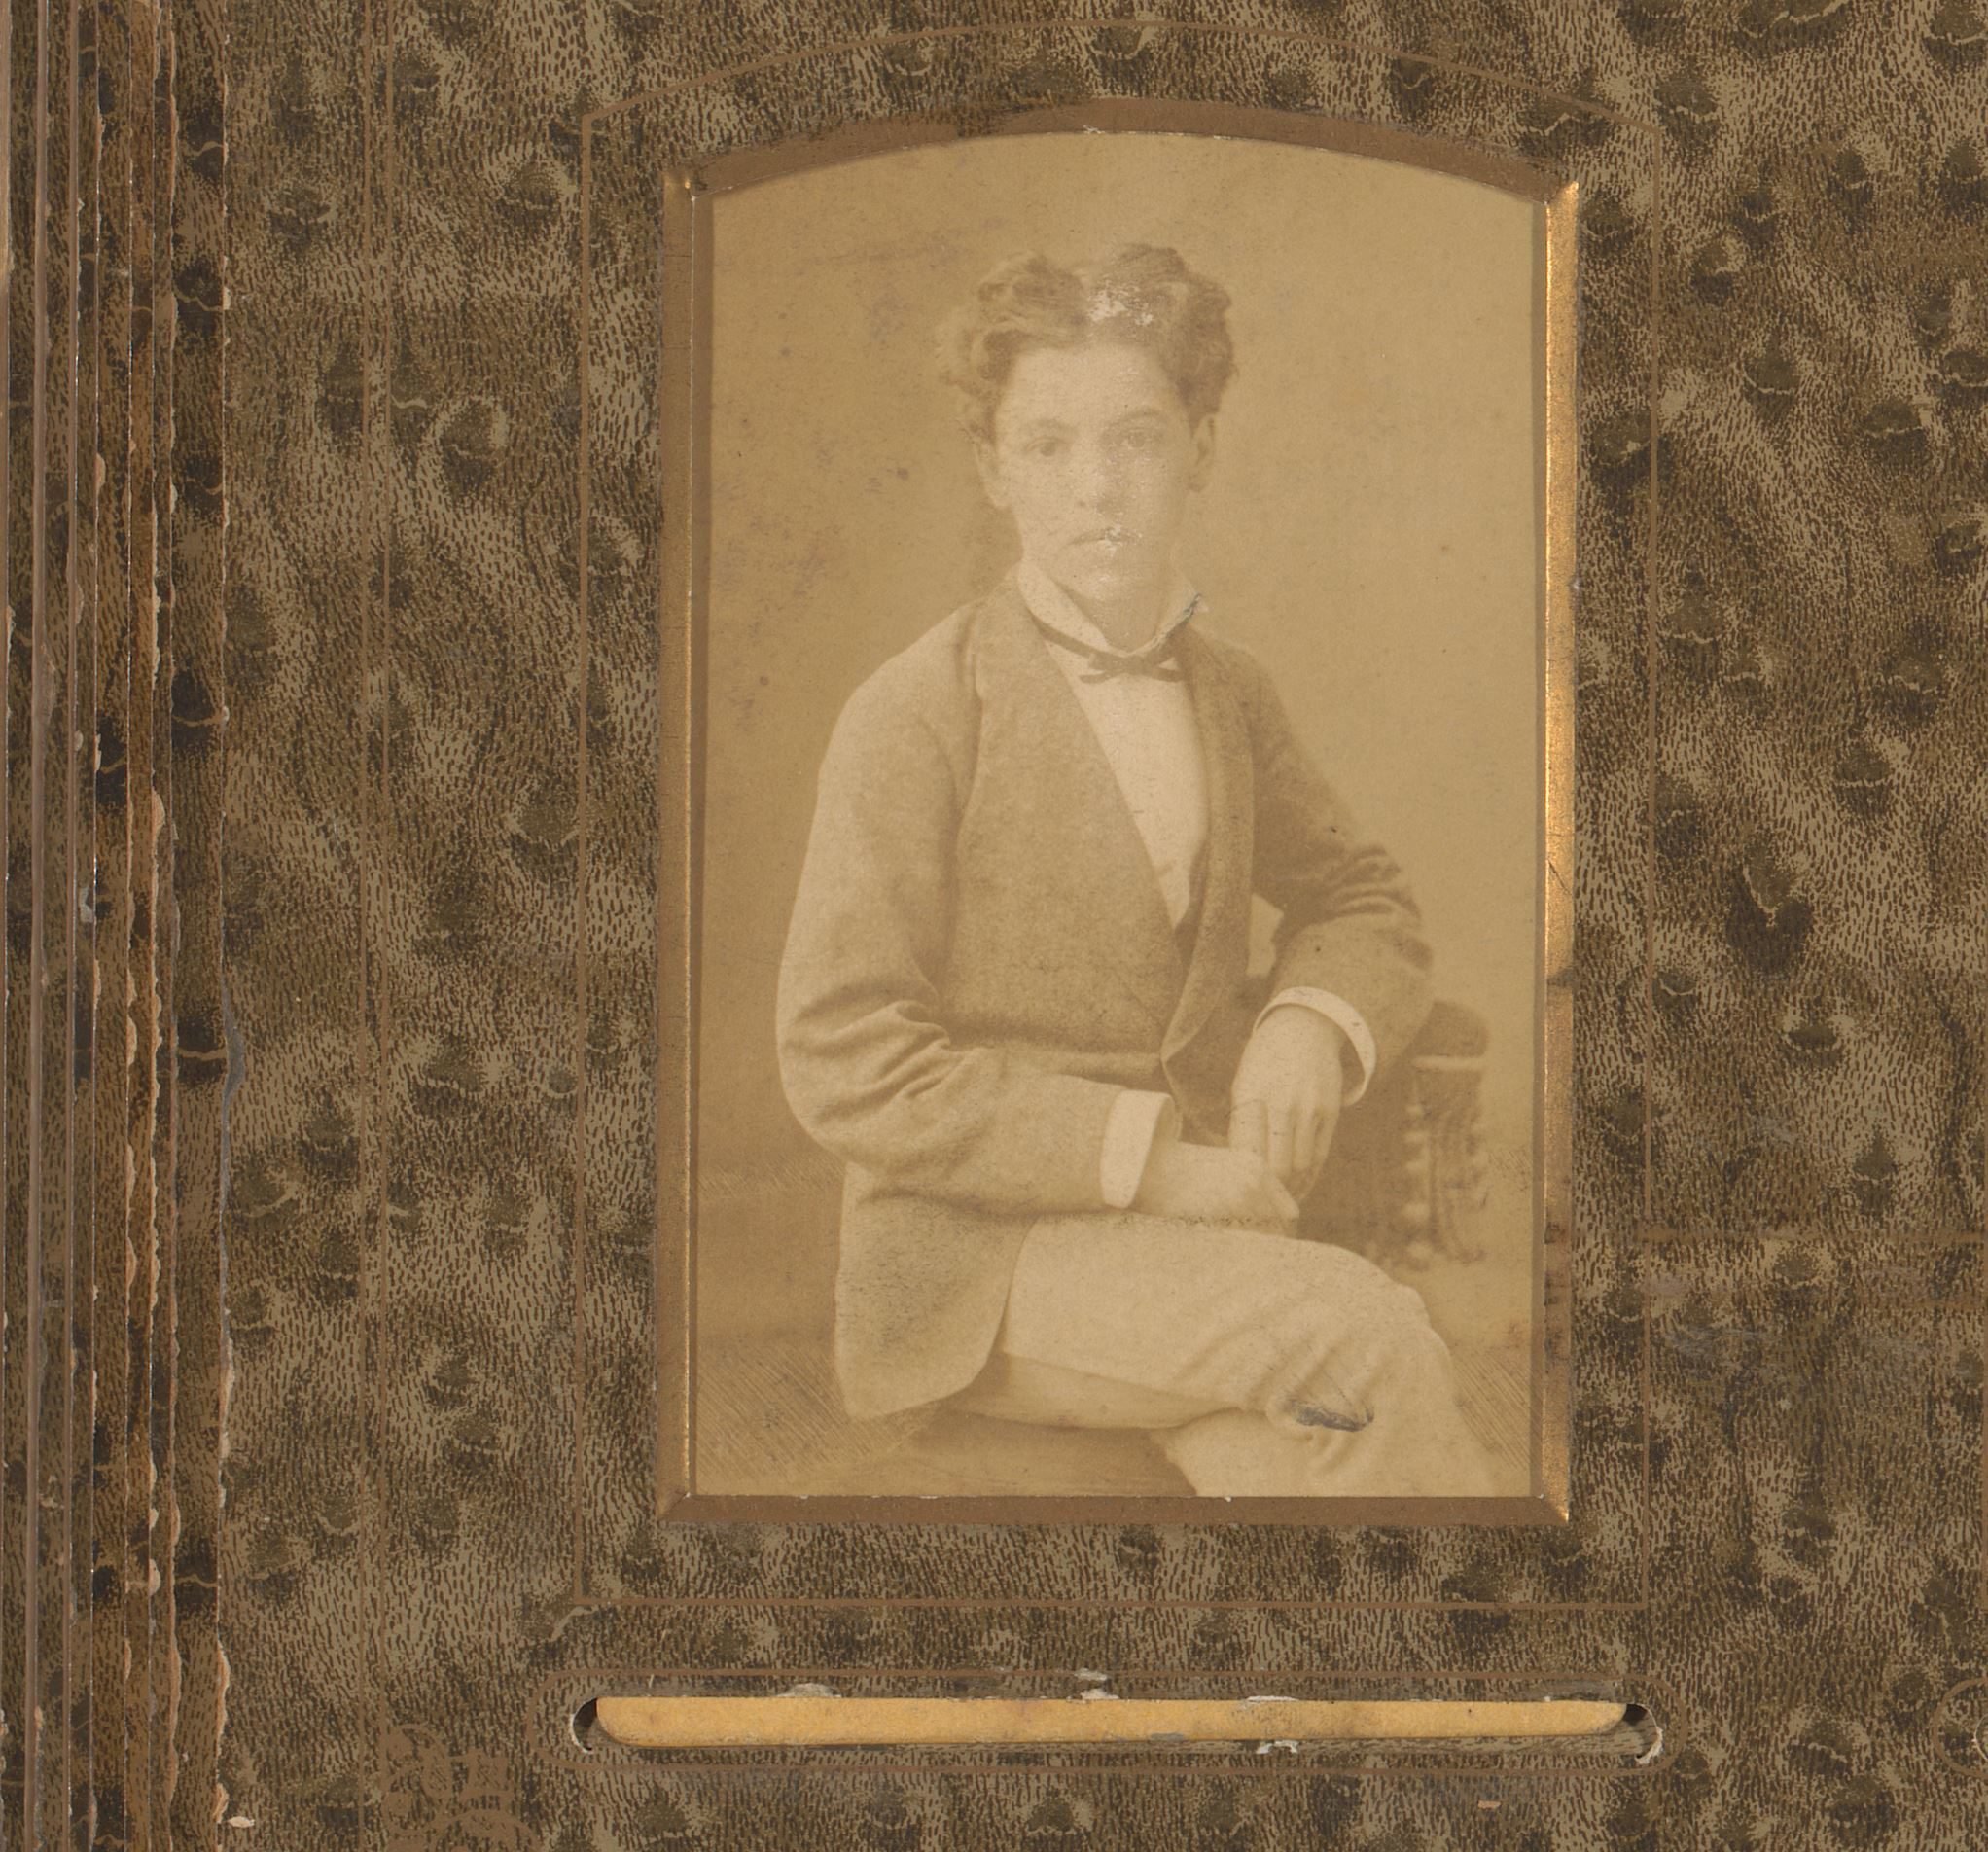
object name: carte de visite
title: Portret van een zittende jongen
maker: e. léon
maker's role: fotograaf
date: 1877-1900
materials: cardboard, photographic support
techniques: albumen print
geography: grenoble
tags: sitting figure, historical persons, youth, adolescent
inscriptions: monogram: ‘EL’, inscription: ‘E. LÉON/ 4, Rue Lafayette, 4./ GRENOBLE/ &/ URIAGE LES BAINS/ Les Clichés sont conservés./ 1877’